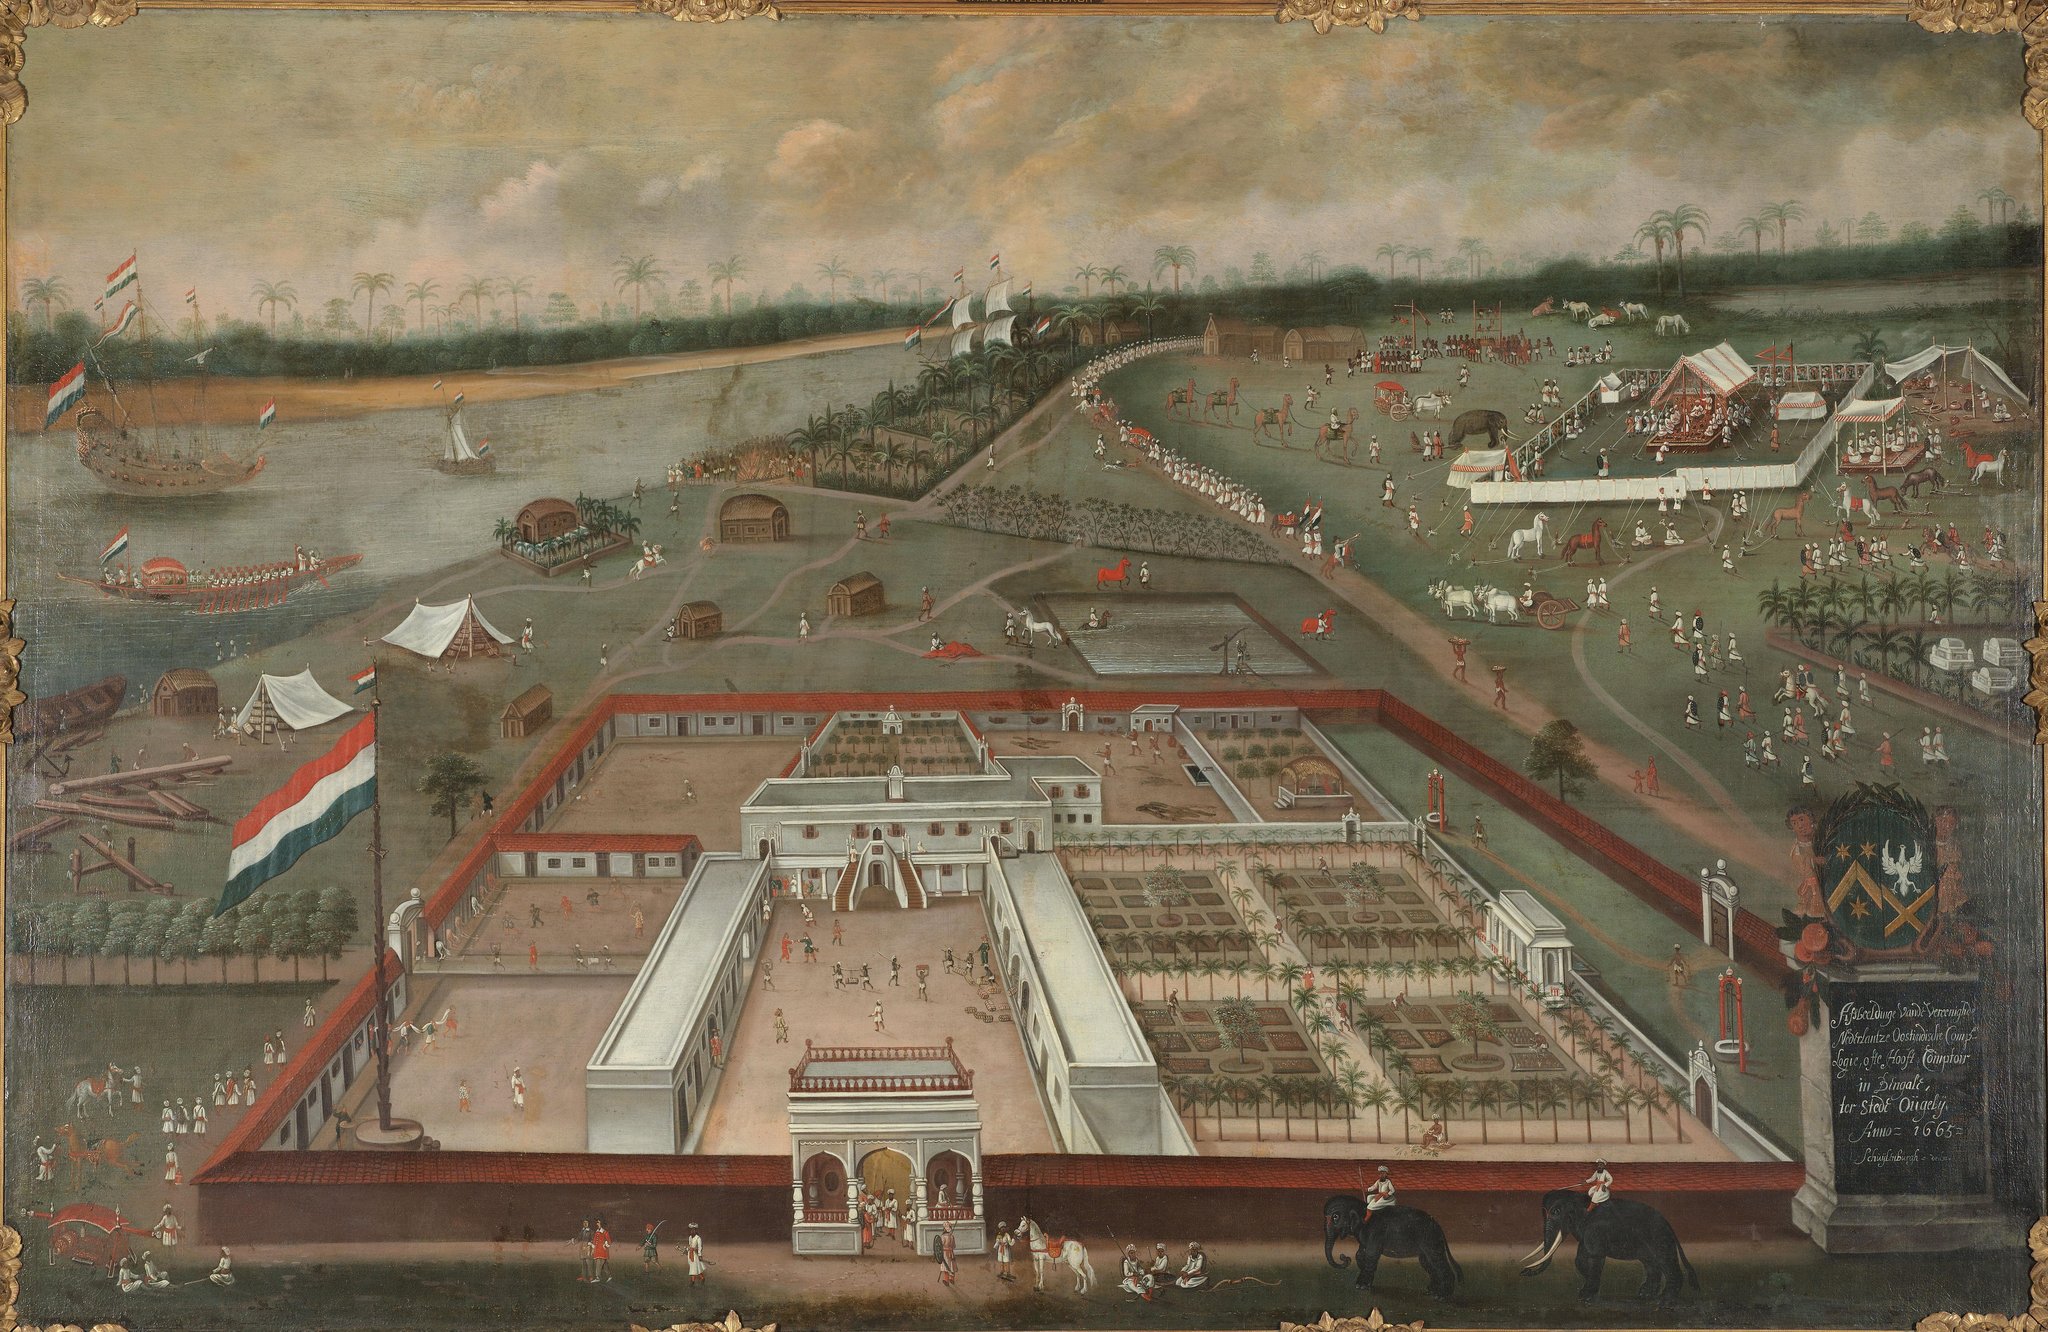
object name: painting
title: The Trading Post of the Dutch East India Company in Hooghly, Bengal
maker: hendrik van schuylenburgh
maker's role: painter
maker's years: 1620-1689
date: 1665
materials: canvas, oil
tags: trade-company, river, locations for trading, landscapes in the non-temperate zone, exotic landscapes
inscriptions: coat of arms, lower right, above the pedestal: divided vertically. 1: a gold chevron and three gold stars, two above and one below, on a dark green (originally blue) field. 2: a silver eagle above a gold saltire, on a dark green (originally blue) field, signature, date and inscription, lower right, on the pedestal: ‘Afsbeeldinge Vande Vereenighde / Nederlantze Oostindische Compas / Logie, ofte Hooft Comptoir / in Bengale, / ter Stede Oügelij, / Anno= 1665= / Schuijlenburgh = deiln.’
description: There is much activity in and around the fort at the trading post in Hougly, Bengal (northeast India): ships of the Dutch East India Company (VOC) sail along the Ganges River, the director visits an Indian ruler and enslaved people are at work. In the 17th century Bengal was one of the places where the VOC and its employees bought the most people. They transported them to other VOC trading posts around the Indian ocean.